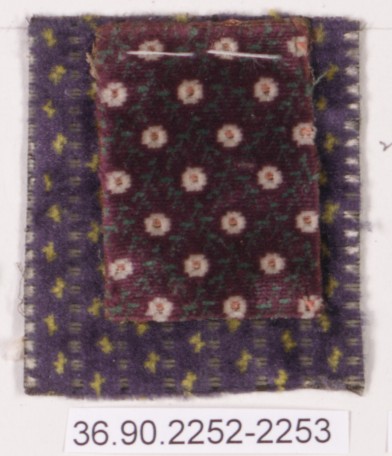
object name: piece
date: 1801-1900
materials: silk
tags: flowers